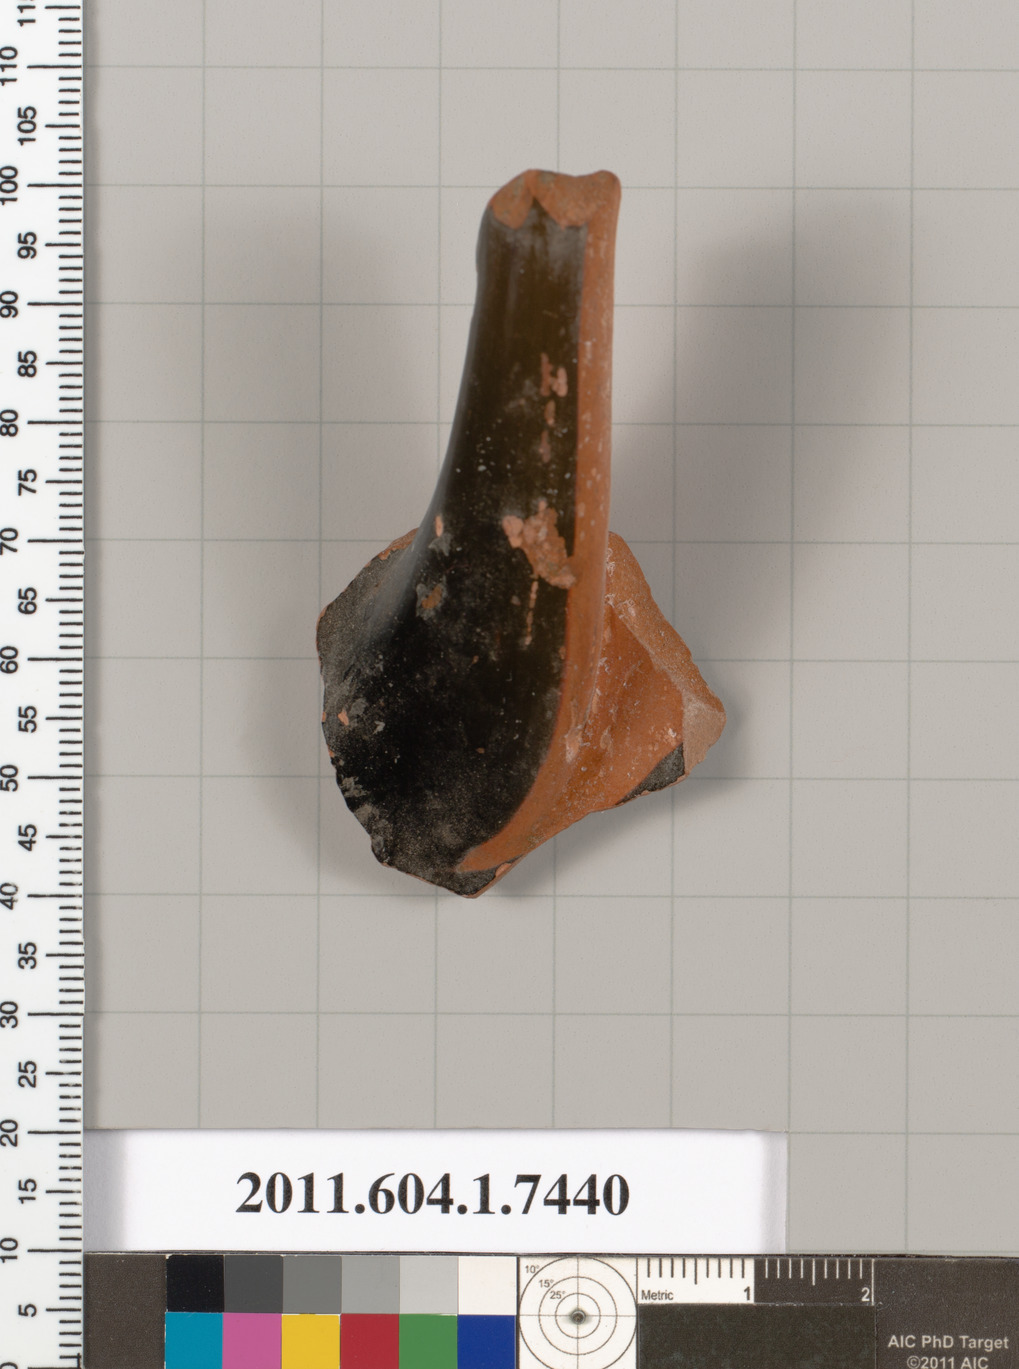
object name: kylix fragment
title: Terracotta fragment of a kylix (drinking cup)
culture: greek, attic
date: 490-470 BCE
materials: terracotta